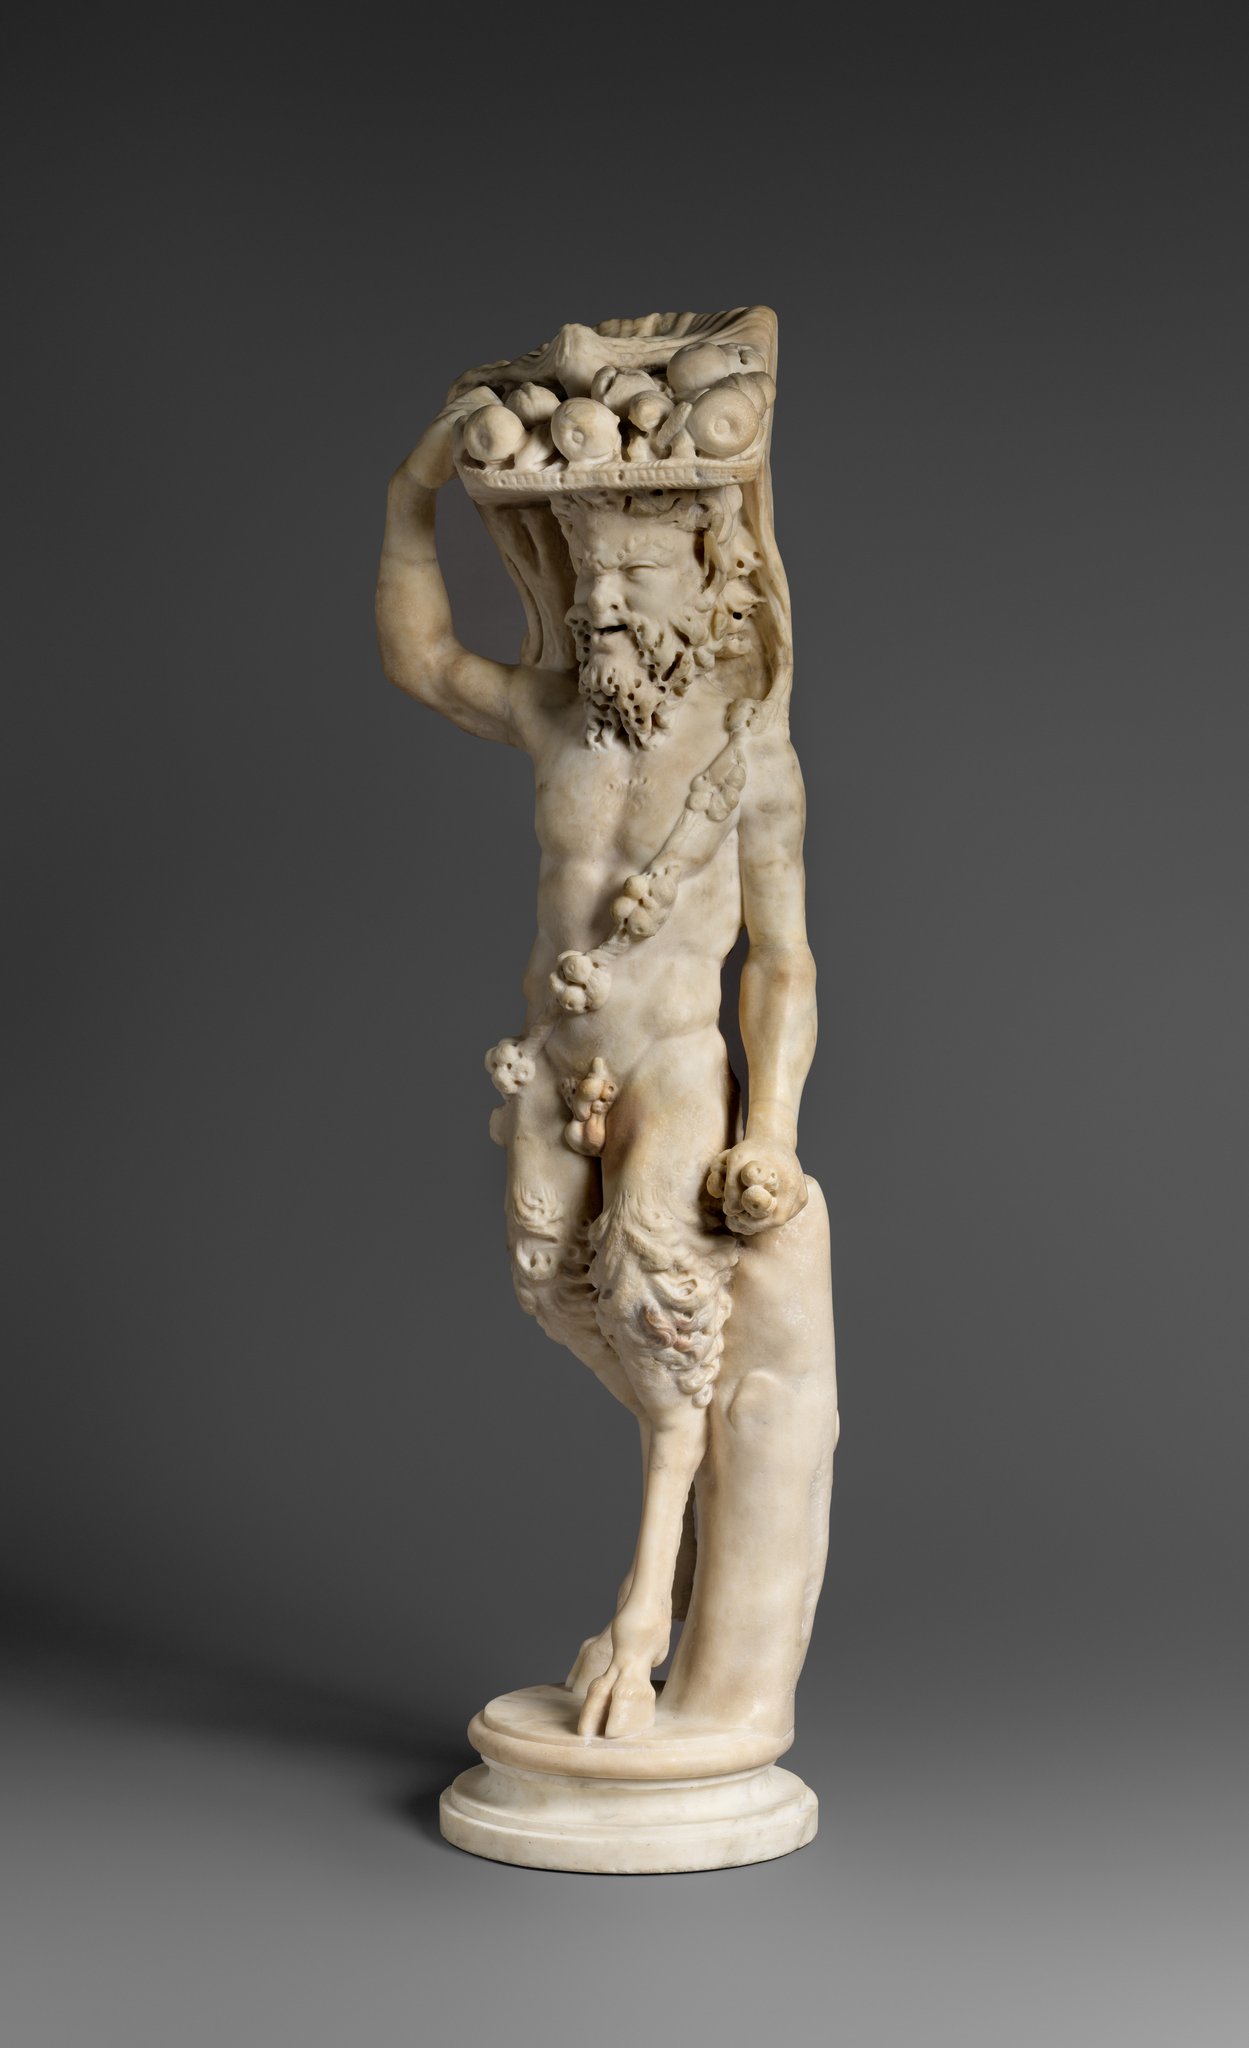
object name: statuette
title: Marble statue of Pan/ Pan or Satyr with winnowing basket filled with offerings and cultic objects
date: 101-200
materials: marble